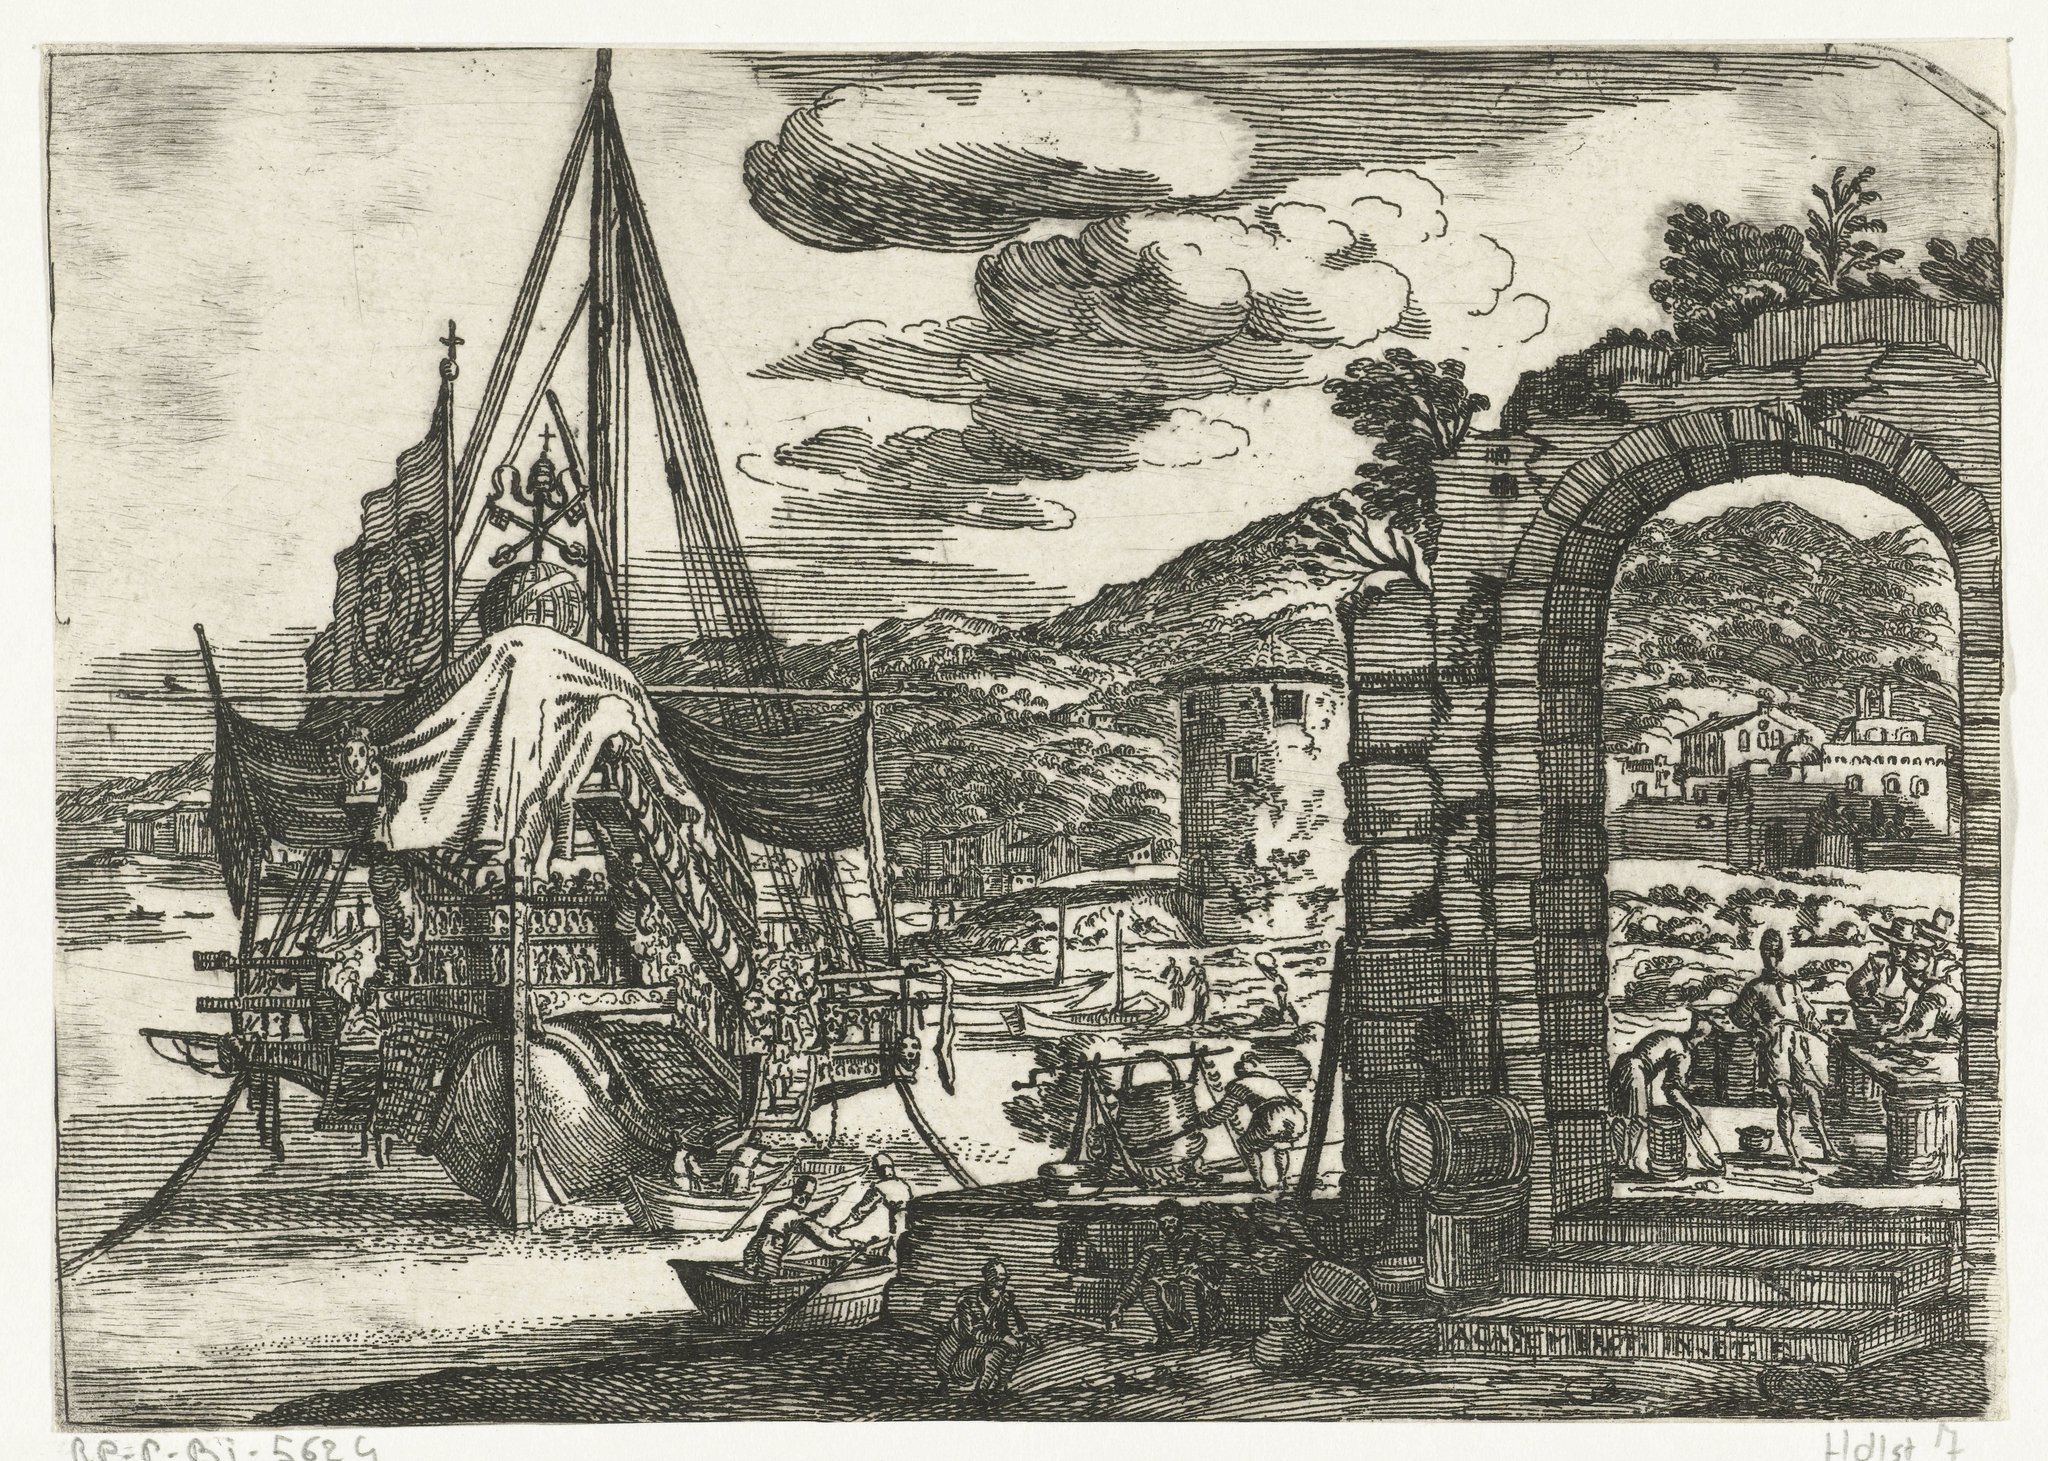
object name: print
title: Gezichten van de haven van Messina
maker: abraham de casembroot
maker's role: draughtsman, print maker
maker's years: 1573-1658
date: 1603-1658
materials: paper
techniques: etching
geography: southern netherlands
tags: harbour, warfare; military affairs (+ sailing-ships), quay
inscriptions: collector's mark: Lugt 2166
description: Gezicht op een kade van de haven van Messina. Op de voorgrond ligt een galjoen voor anker. Het schip draagt het devies van de Pauselijke macht. Op de voorgrond een ruïne met enkele handelaren. Prent uit serie van dertien prenten met gezichten van de haven van Messina